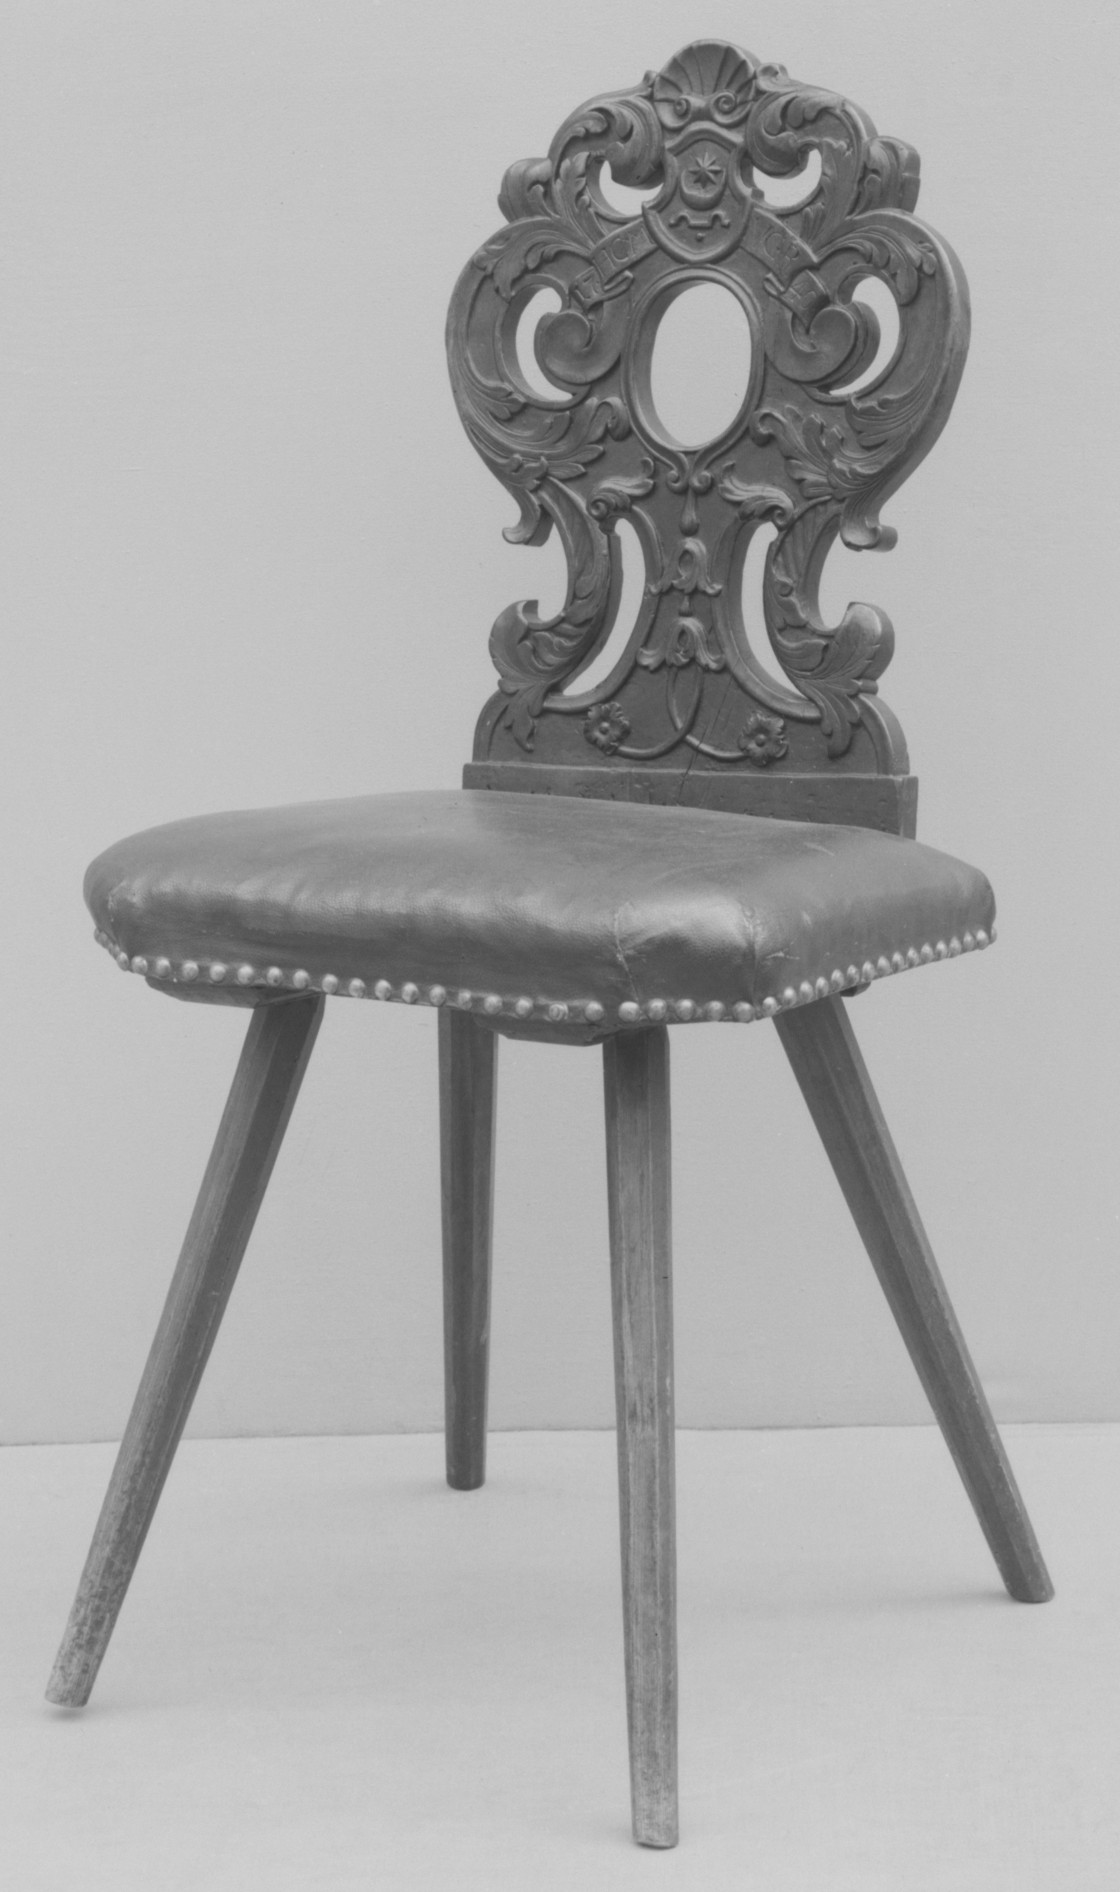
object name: chair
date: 1740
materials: wood